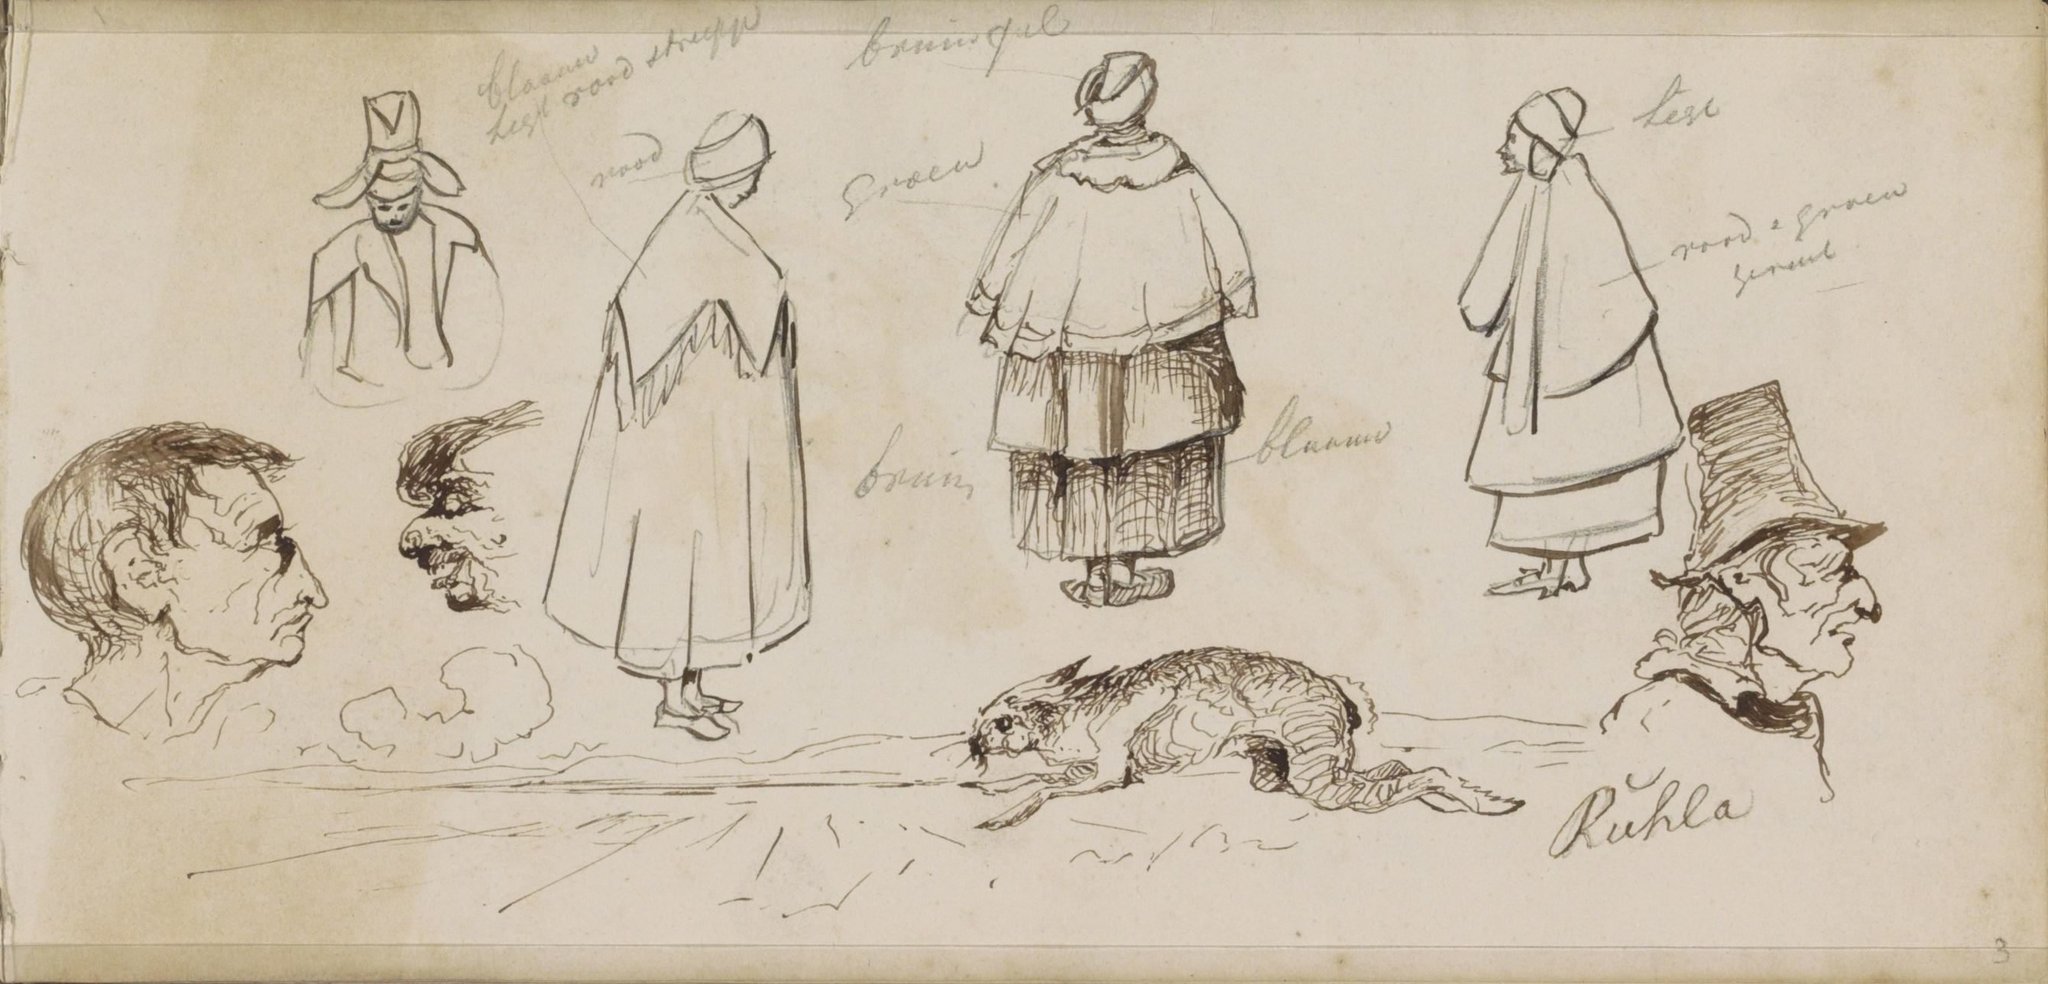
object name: sketchbook leaf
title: Haas, vrouwen in mantels met kappen en mannenkoppen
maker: johannes tavenraat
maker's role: draughtsman, painter, print maker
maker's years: 1809-1881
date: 1840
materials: ink, paper, pencil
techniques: pen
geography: ruhla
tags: head (human), adult woman, rodents: hare, adult man, head-gear: hat, folk costume, regional costume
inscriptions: annotation: ‘Ruhla’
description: Blad 3 recto uit een schetsboek met 63 bladen.